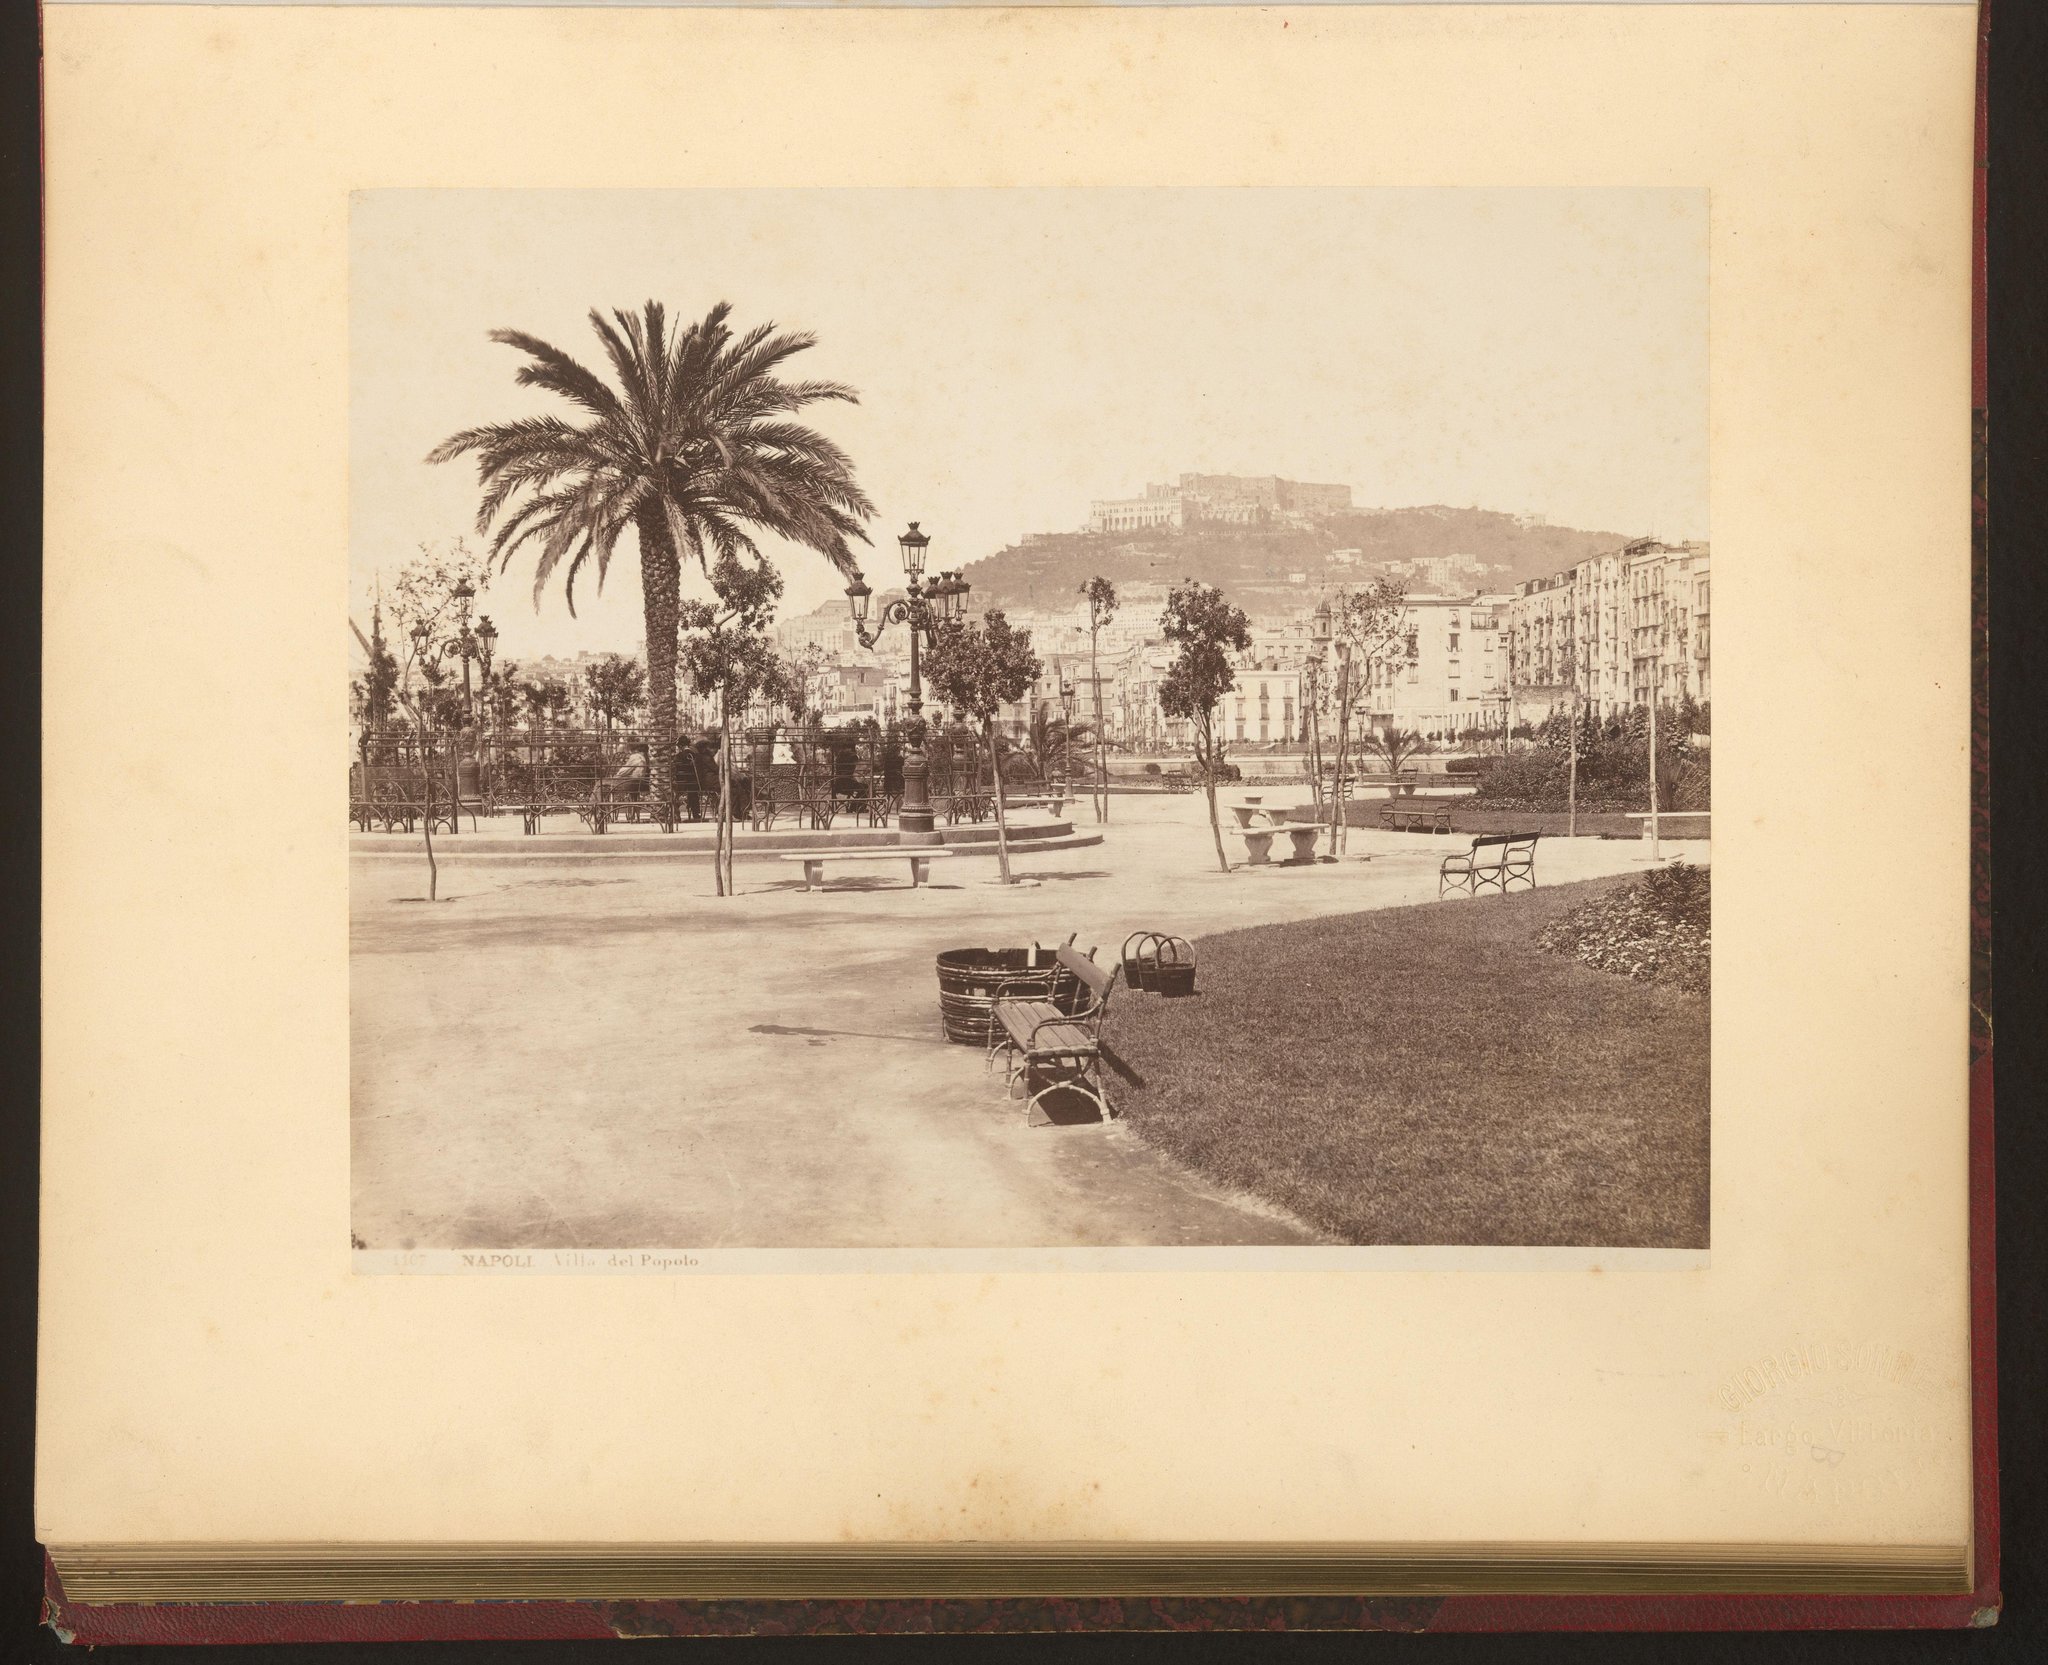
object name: album leaf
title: Gezicht op Villa del Popolo te Napels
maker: giorgio sommer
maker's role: fotograaf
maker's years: 1834-1914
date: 1874-1879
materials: photographic support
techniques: albumen print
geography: naples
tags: trees: palm-tree, public gardens, park, naples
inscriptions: workshop stamp: ‘Giorgio Sommer/ Largo Vittoria/ Napoli’, number: ‘4107’